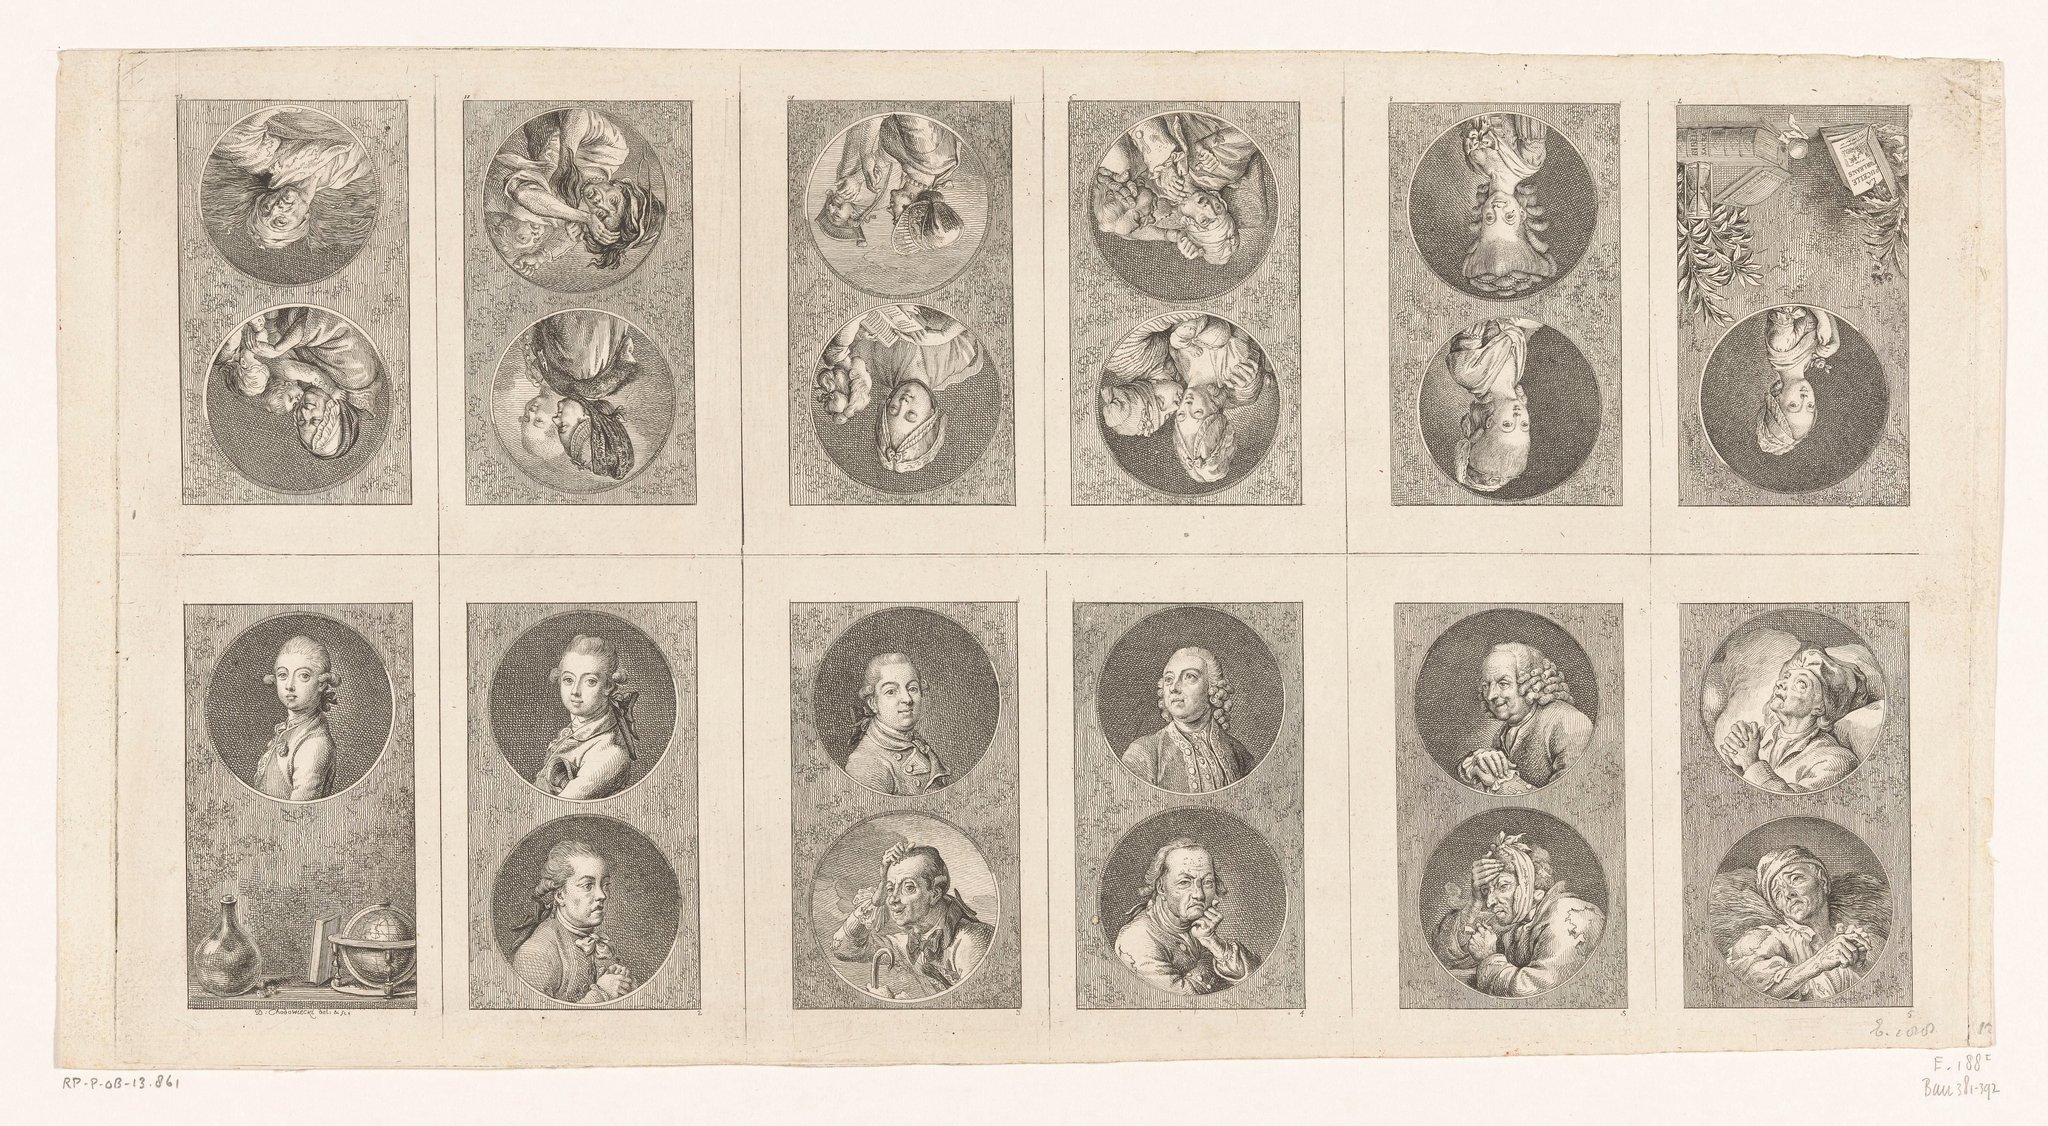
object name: print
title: Gezichten van mannen en vrouwen in verschillende fases van hun leven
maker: daniel nikolaus chodowiecki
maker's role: draughtsman, print maker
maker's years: 1726-1801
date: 1777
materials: paper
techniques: etching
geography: berlin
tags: head (human), book, hourglass, globe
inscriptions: collector's mark: Lugt 240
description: Beide series tonen de gevolgen van een deugdelijke (boven) en een onzedelijke levensloop (onder). Het eerste gezicht (een jonge man of vrouw) vormt het uitgangspunt voor beide series. De gezichten zijn genummerd van 1 tot en met 12.